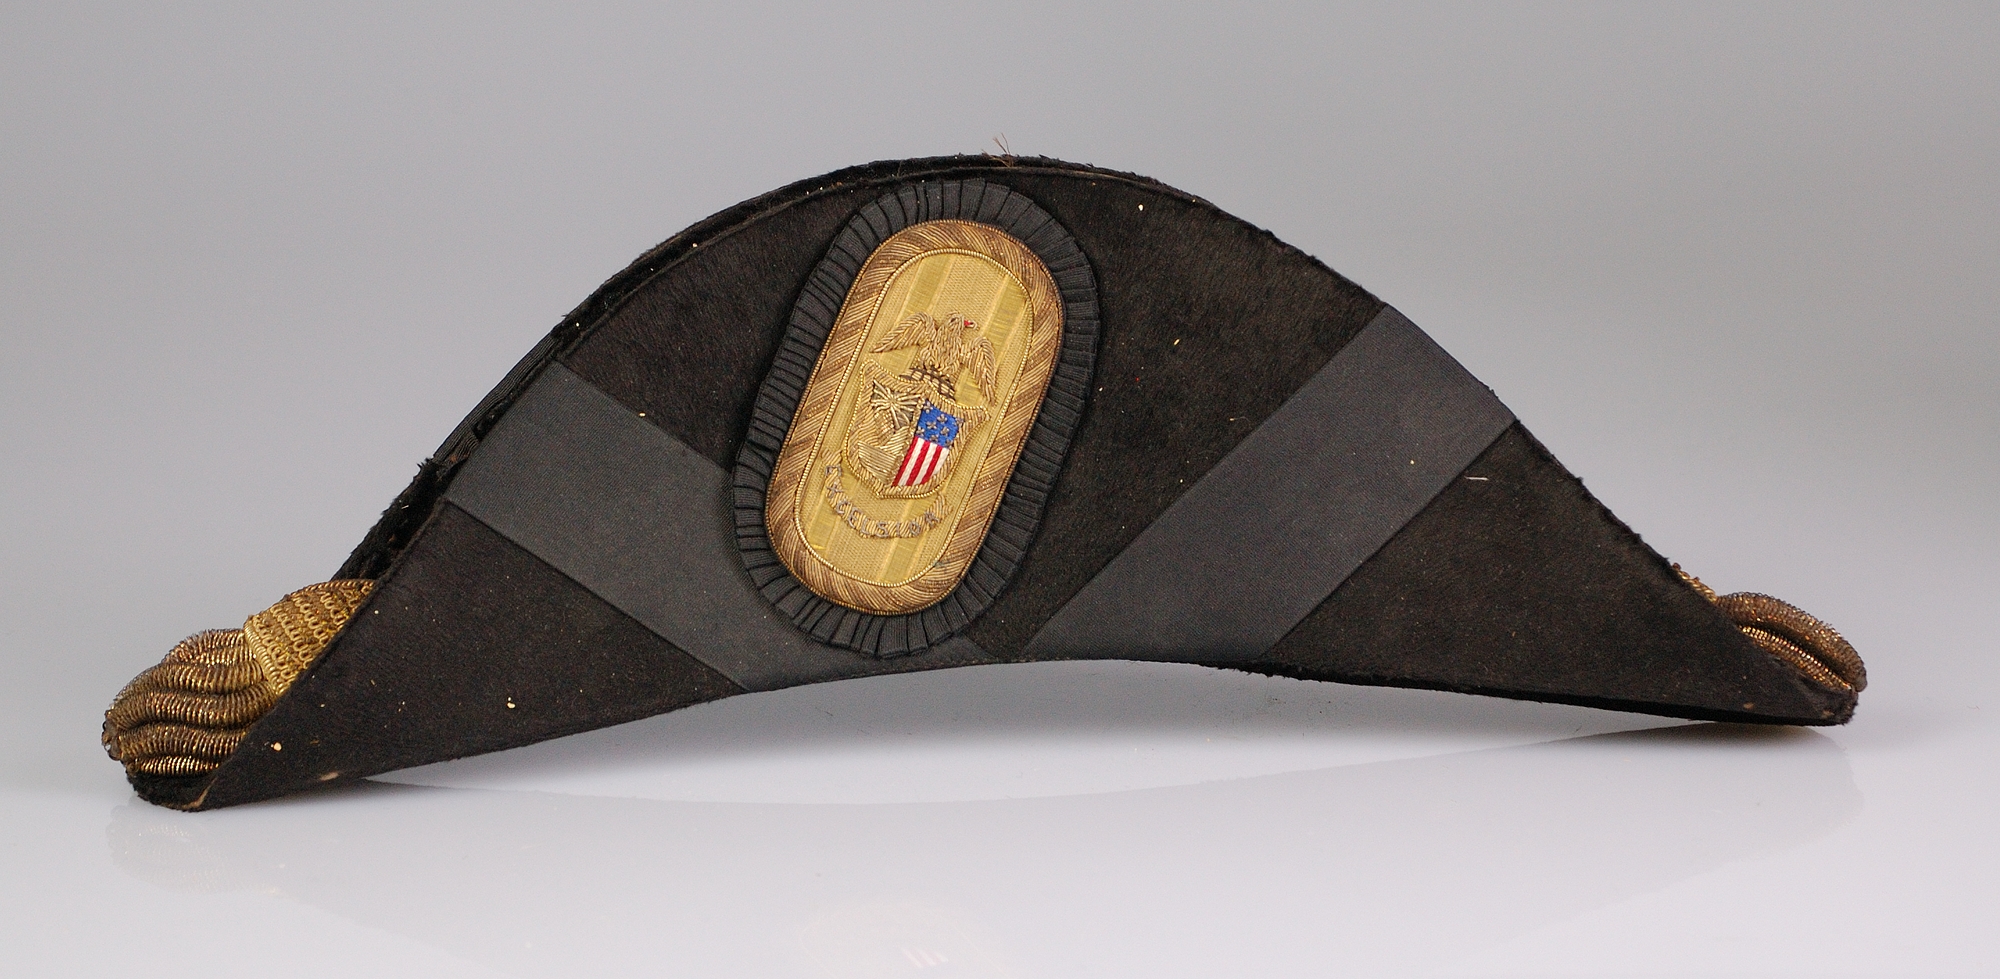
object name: bicorne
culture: american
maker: shannon, miller & crane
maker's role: designer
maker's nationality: american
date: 1867-1900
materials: fur, silk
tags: navy